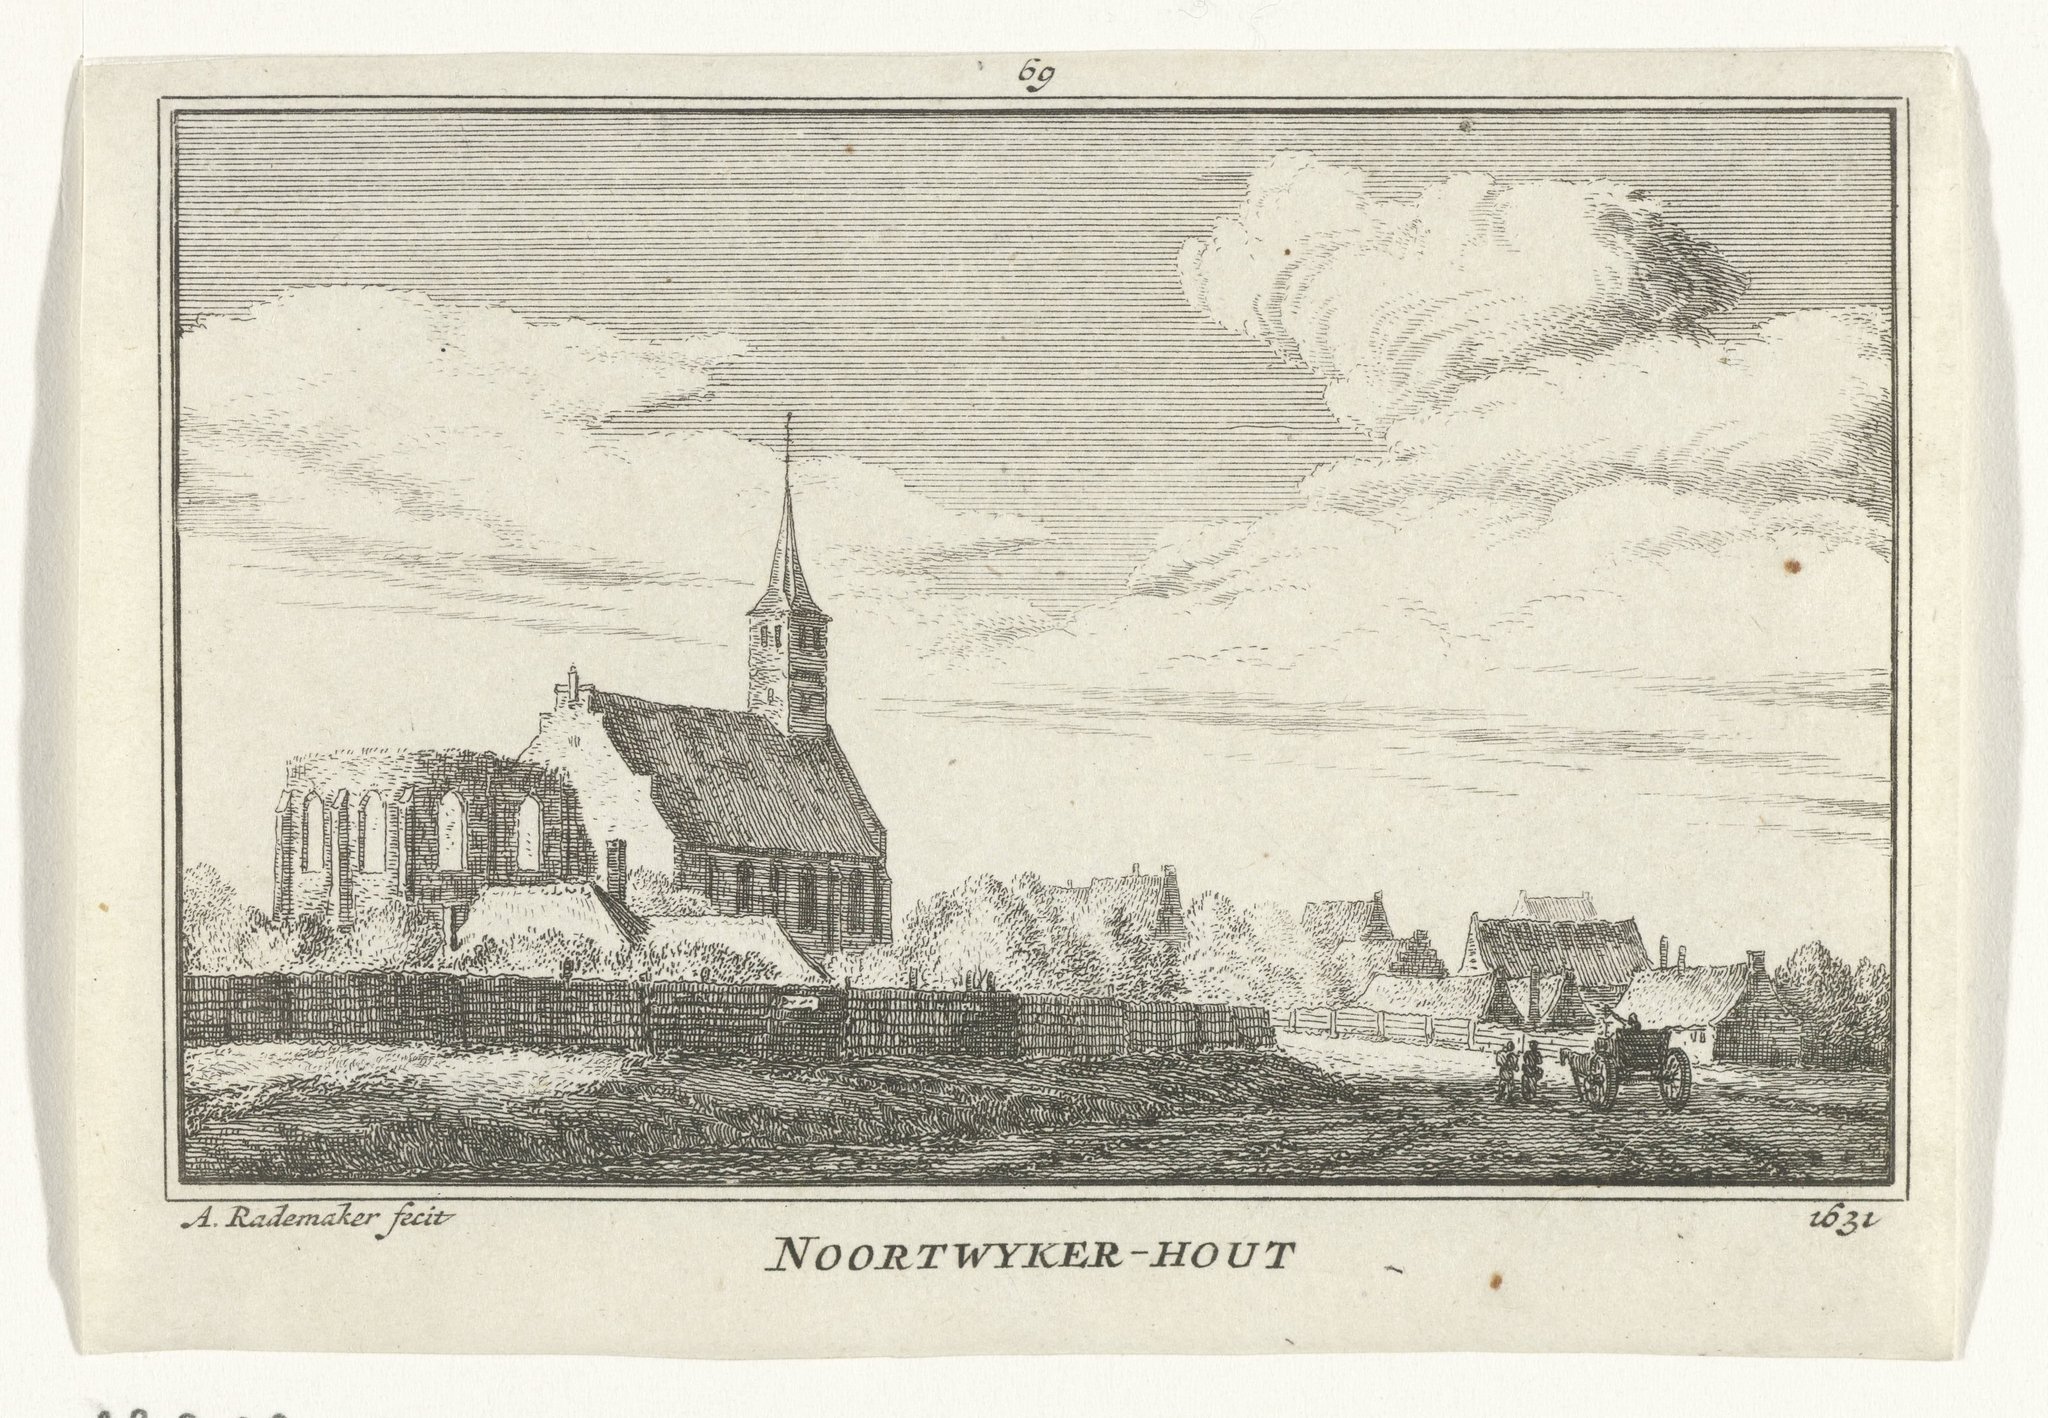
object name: print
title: Noortwyker-Hout 1631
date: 1727-1733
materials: paper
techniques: etching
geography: amsterdam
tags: prospect of village, silhouette of village, church (exterior), ruin of church, monastery, etc., two-wheeled vehicle drawn by one animal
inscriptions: collector's mark: Lugt 2228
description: Illustratie uit: Abraham Rademaker, Matthaeus Brouërius van Niedek, Isaac Le Long, Kabinet van Nederlandsche en Kleefsche outheden en (...) voorname stads- en landgebouwen, Willem Barents en Antoni Schoonenburg: Amsterdam, 1727-1733, ill. nr. 69.